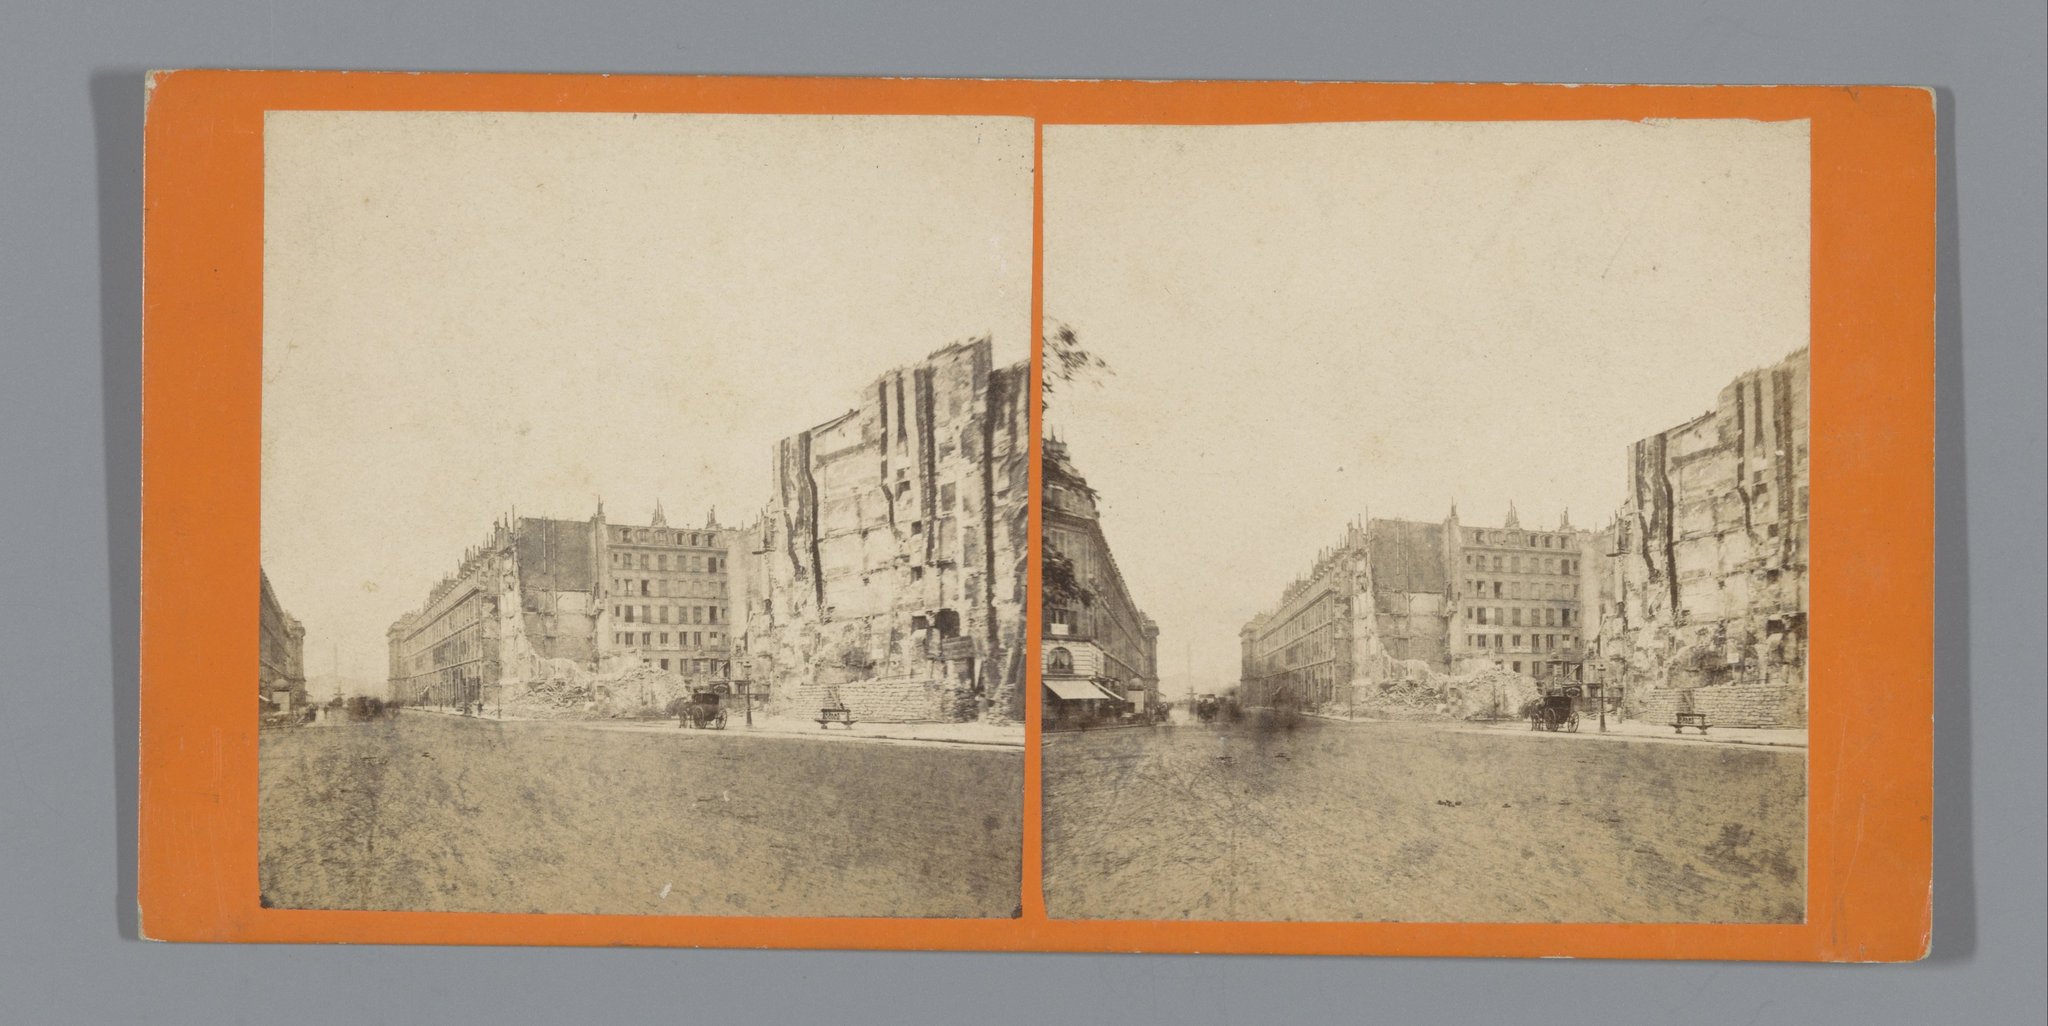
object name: stereograph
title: Ruïnes langs de Steinstraße te Straatsburg na het Beleg van Straatsburg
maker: Anonymous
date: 1870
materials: cardboard, photographic support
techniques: albumen print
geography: straatsburg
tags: ruin of a building ~ architecture, after the battle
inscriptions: inscription: ‘Steinstrasse Straatsburg’